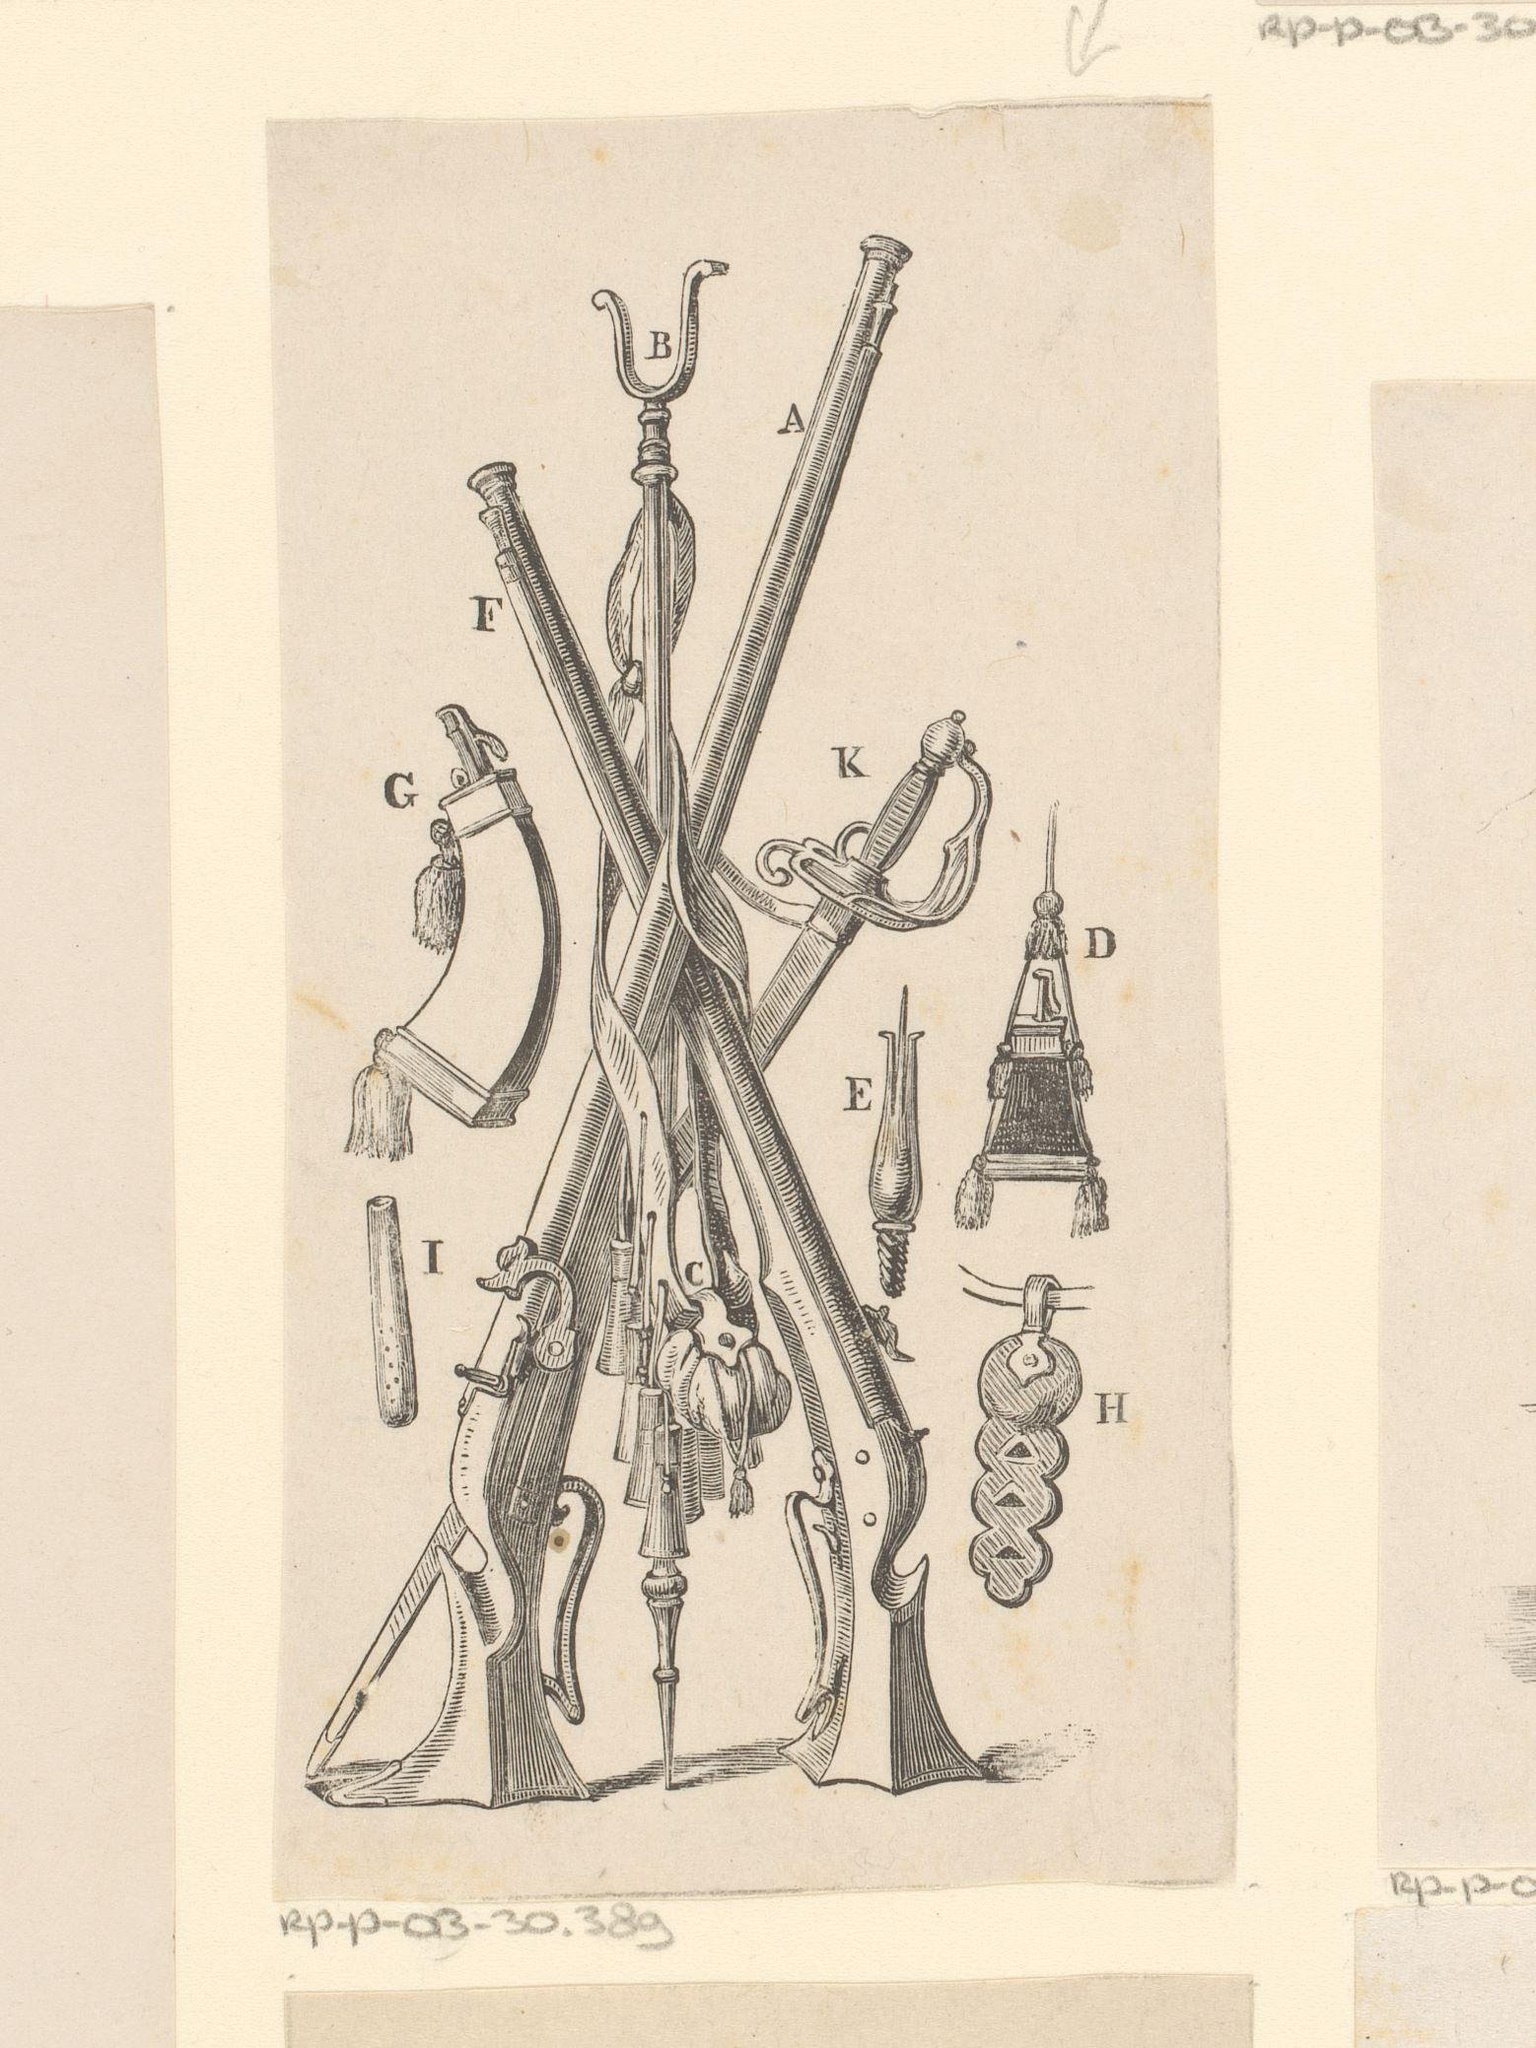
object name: print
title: Wapentuig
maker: isaac weissenbruch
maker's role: print maker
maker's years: 1826-1912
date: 1836-1912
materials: paper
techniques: engraving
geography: netherlands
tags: weapons